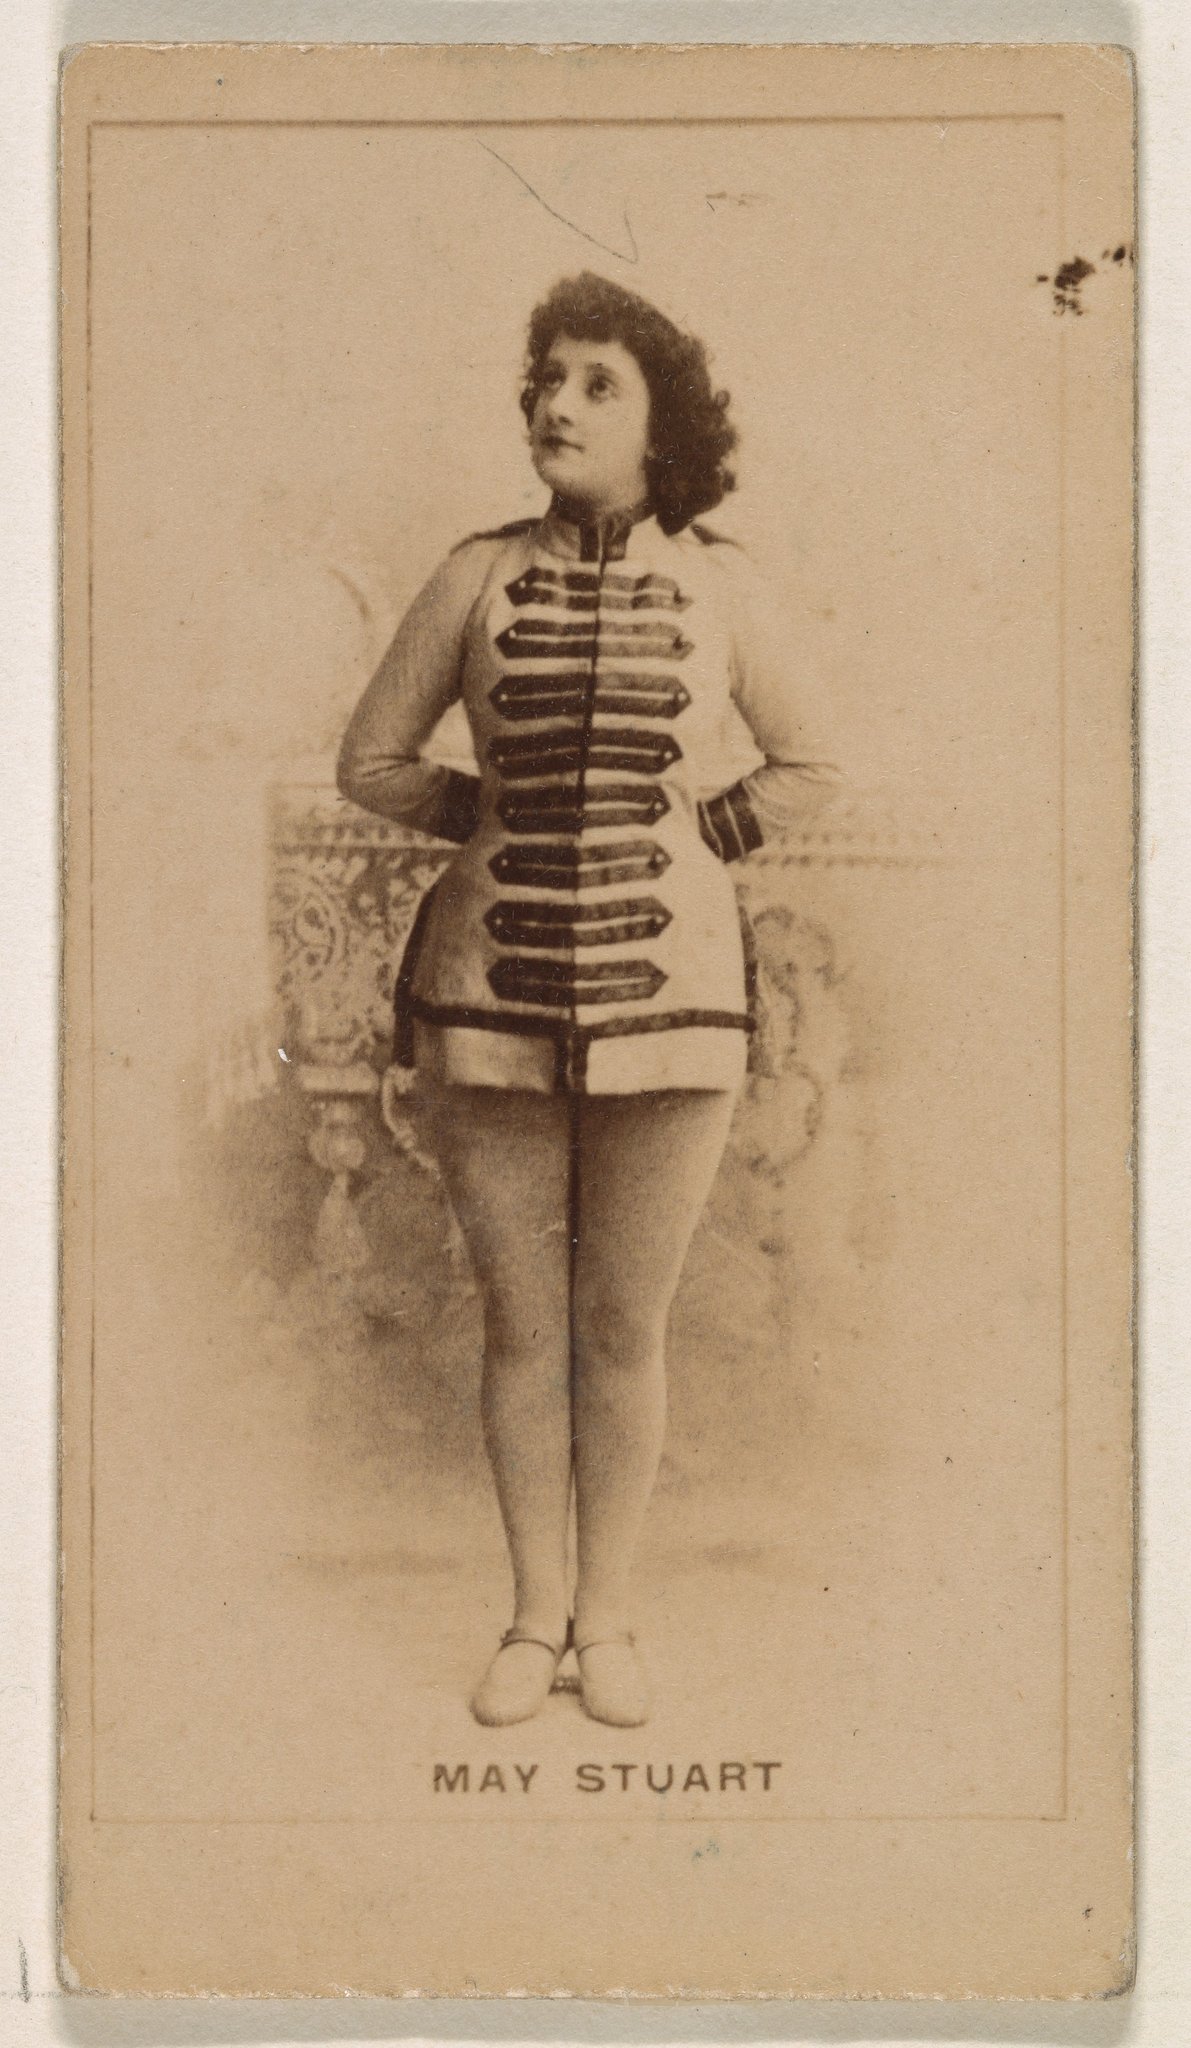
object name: photograph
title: May Stuart, from the Actresses series (N245) issued by Kinney Brothers to promote Sweet Caporal Cigarettes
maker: kinney brothers tobacco company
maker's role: publisher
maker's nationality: american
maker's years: 1869-2011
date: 1890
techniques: albumen silver print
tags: portraits,women,actresses